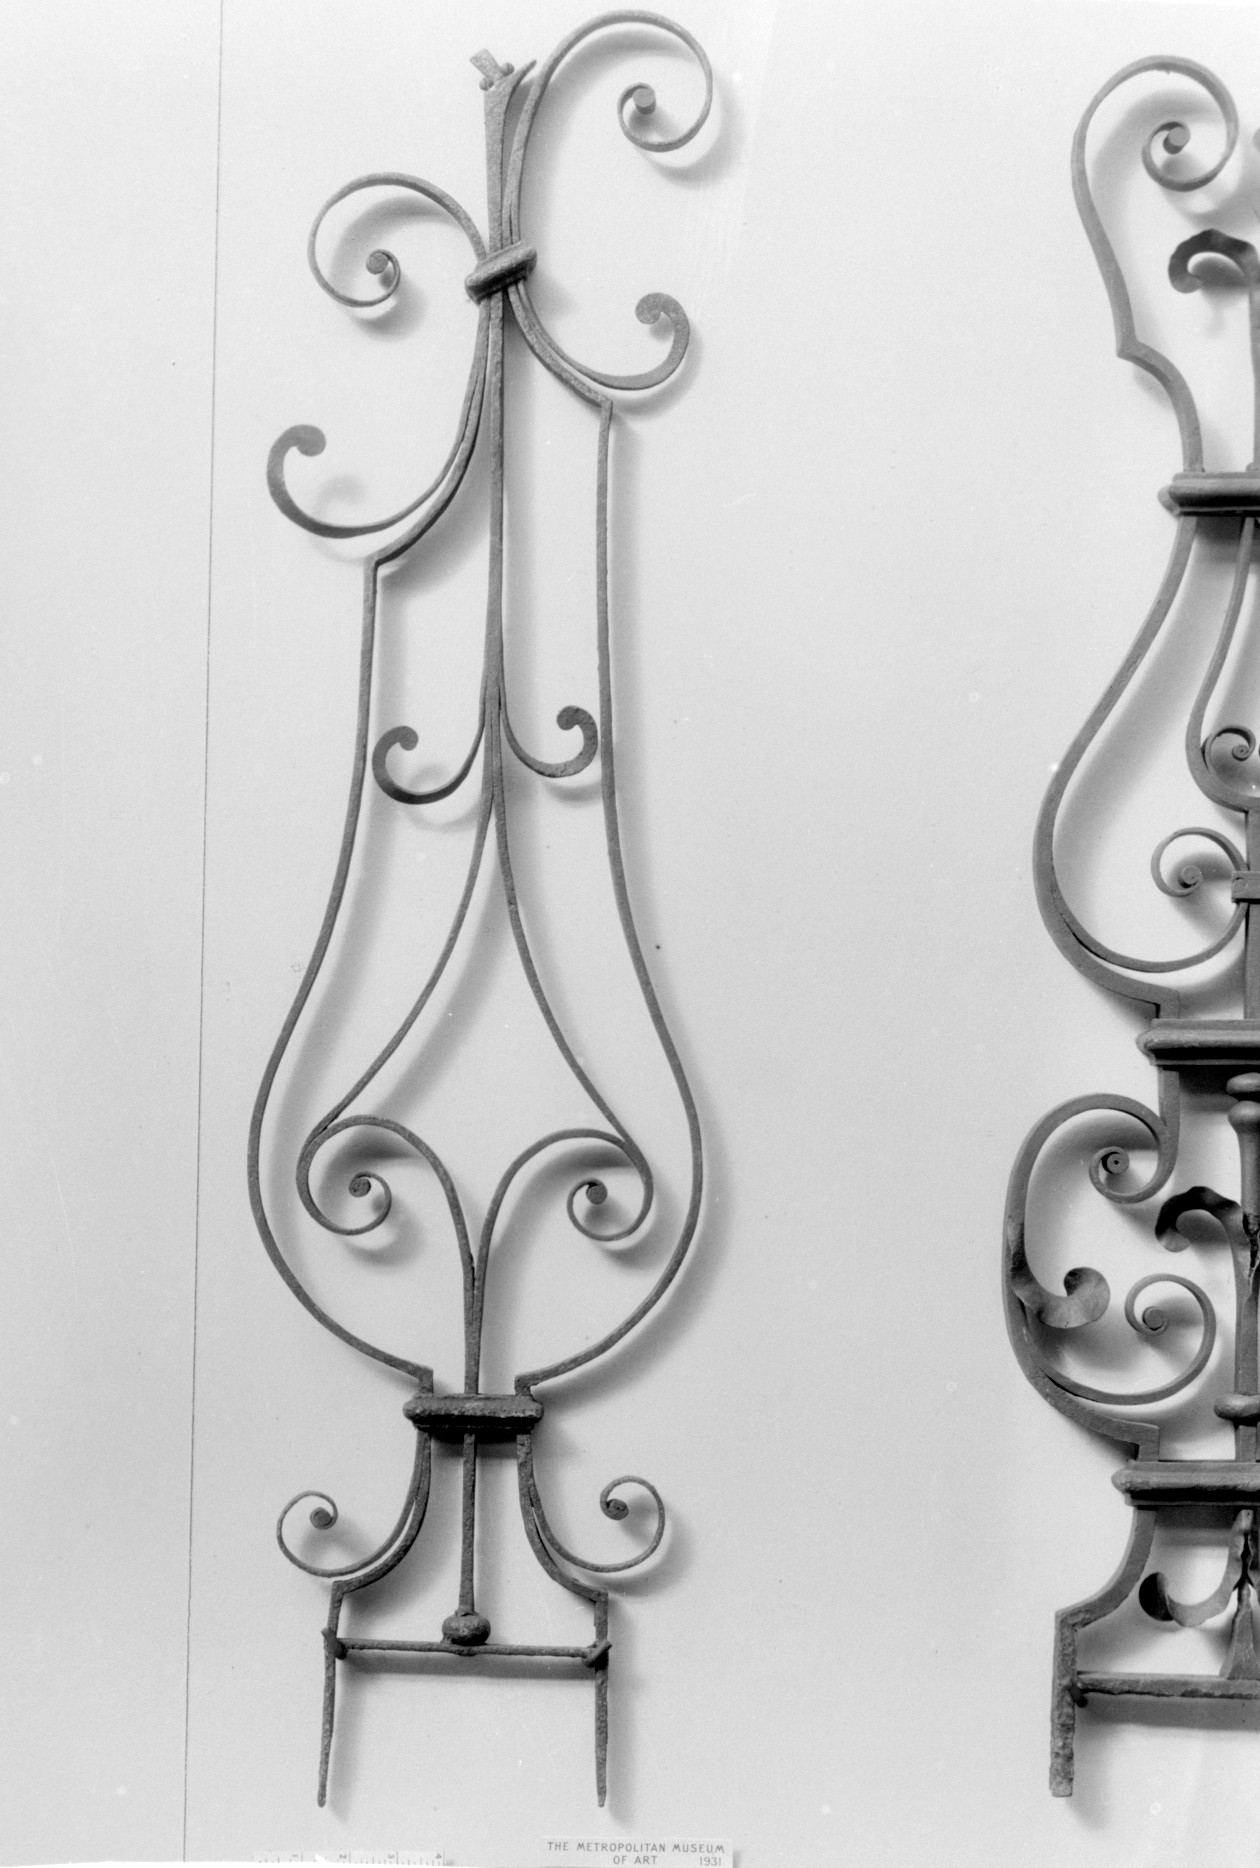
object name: baluster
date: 1750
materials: iron